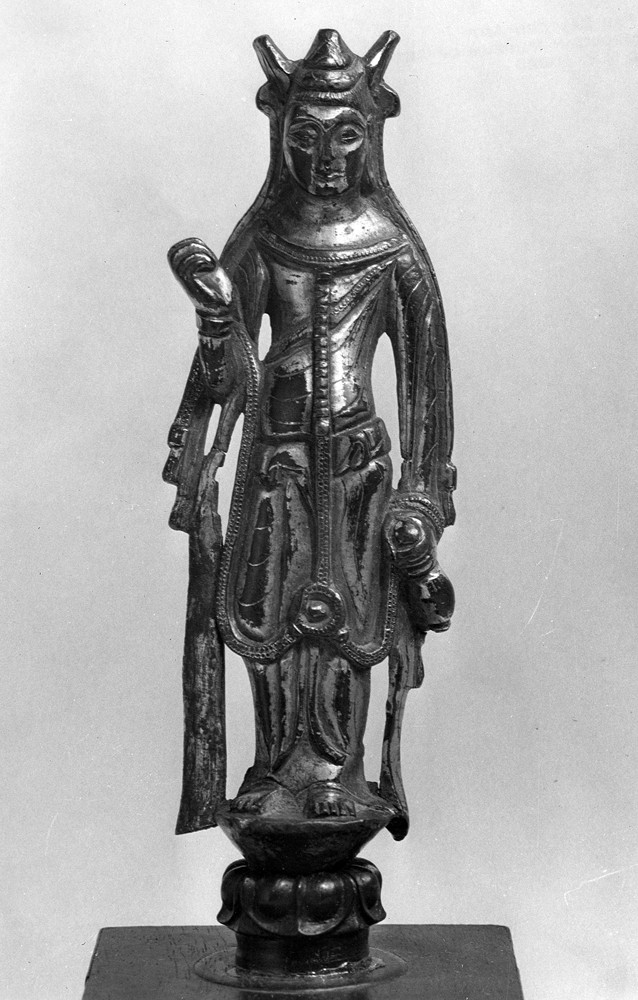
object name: figure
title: Bodhisattva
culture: chinese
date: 589-618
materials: gilt bronze, wood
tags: bodhisattvas